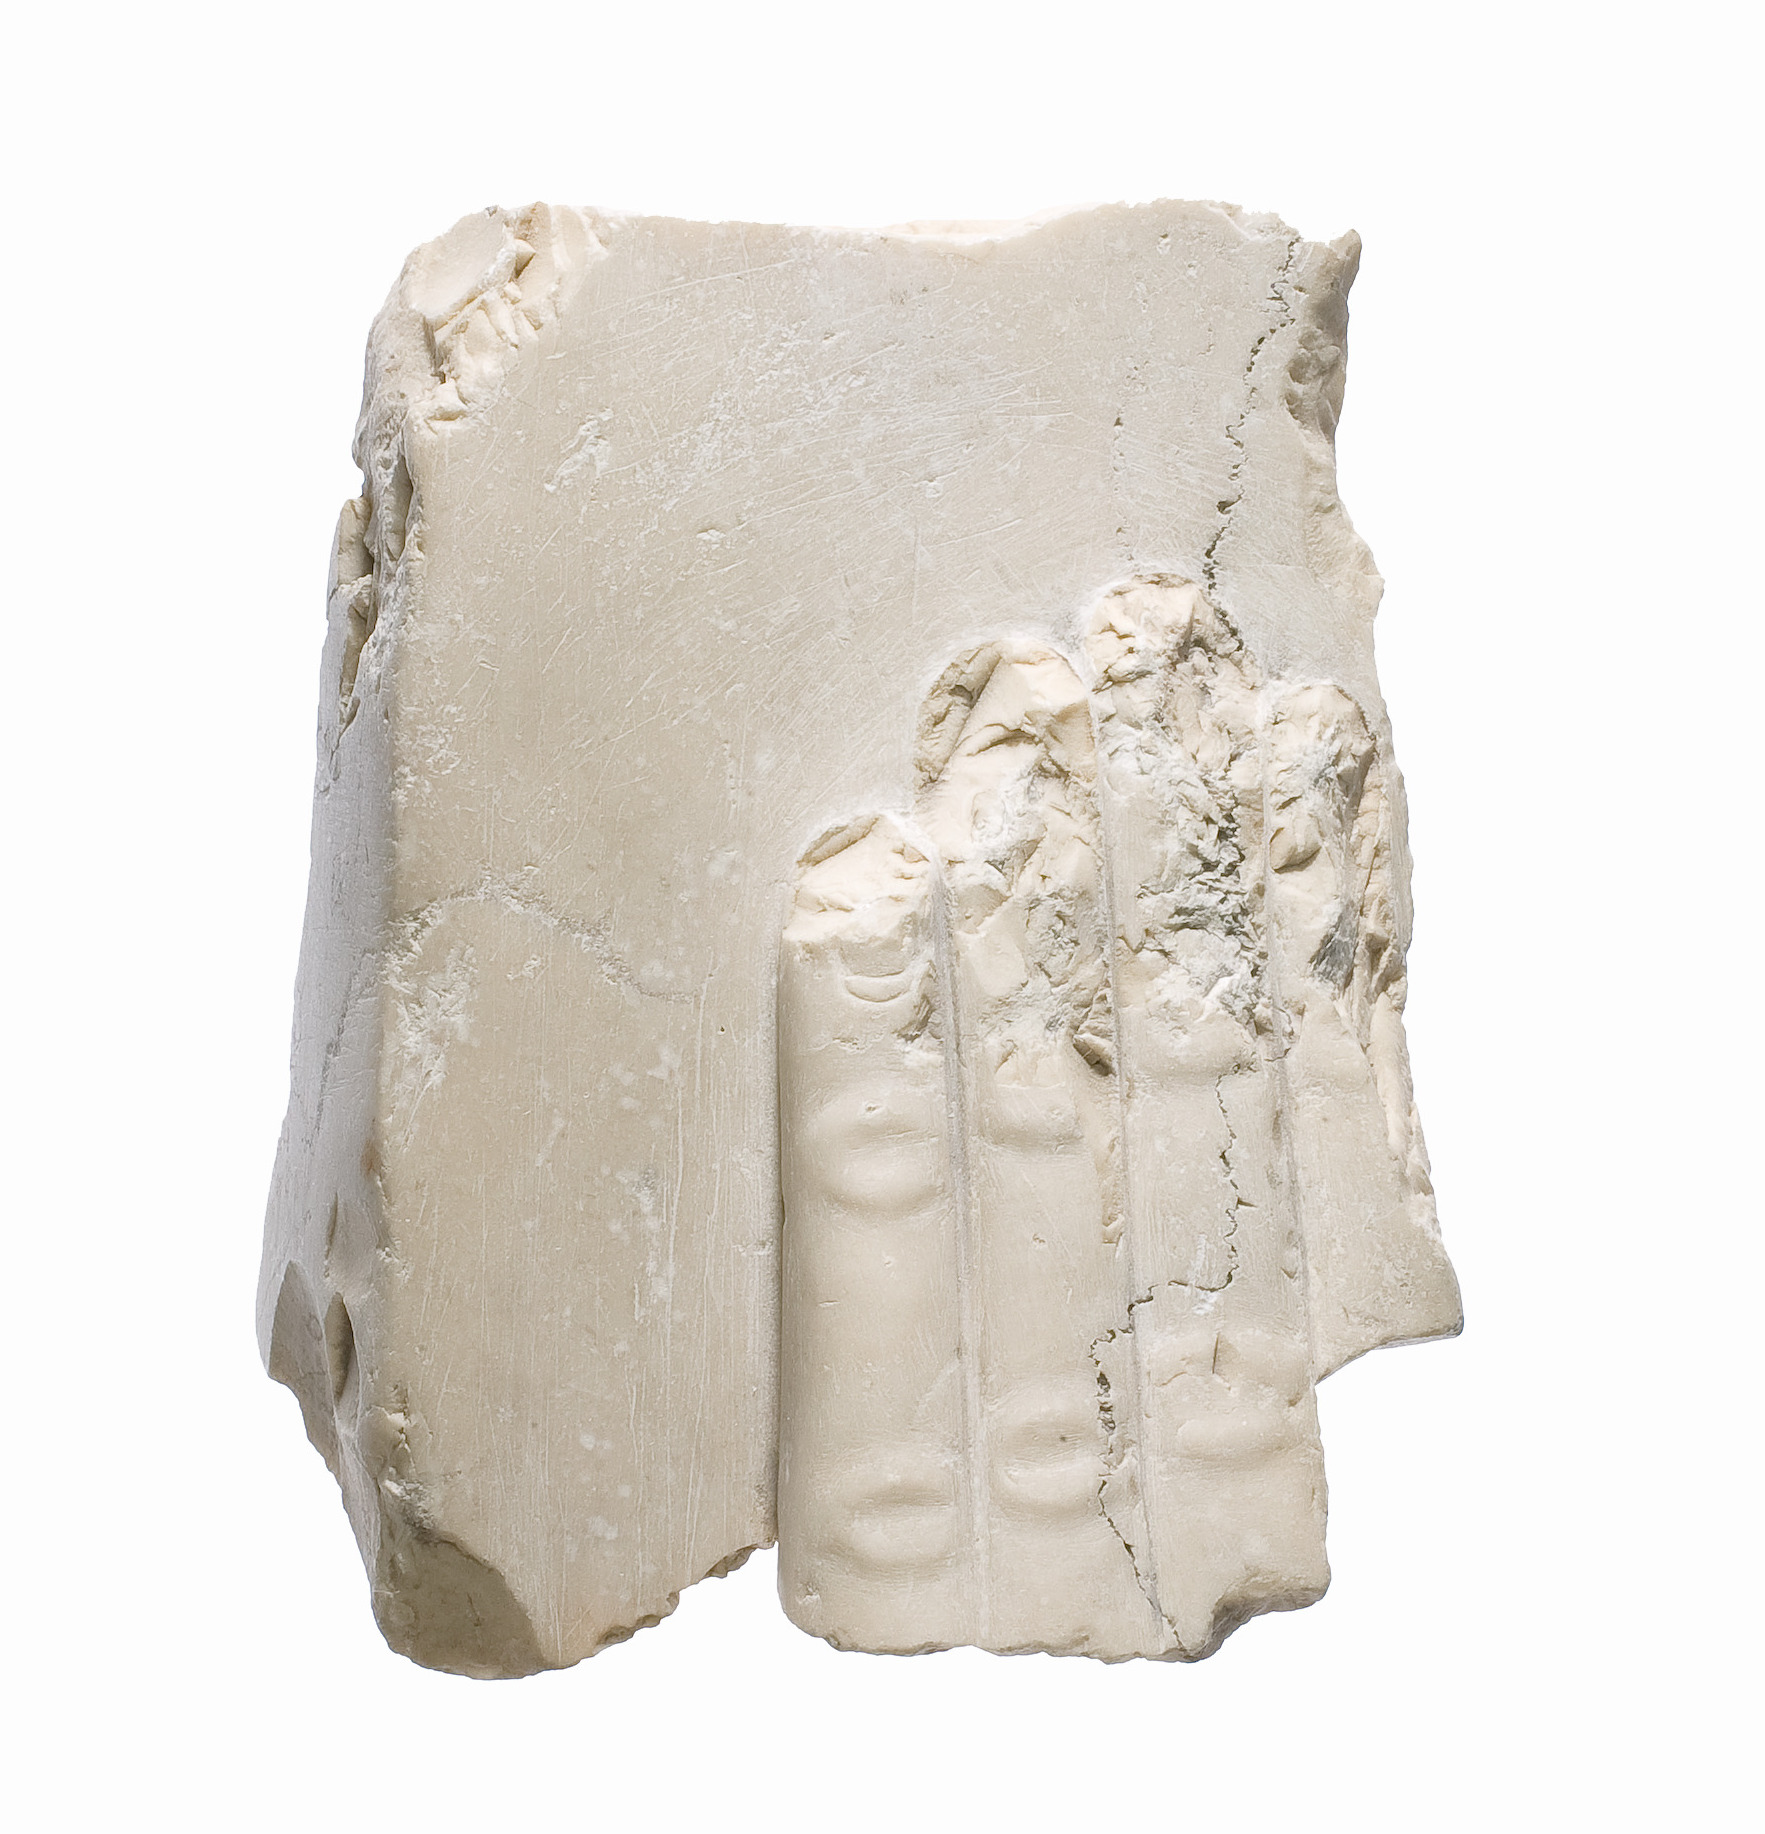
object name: tablet with hand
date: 1353-1336 BCE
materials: limestone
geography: egypt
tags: hands